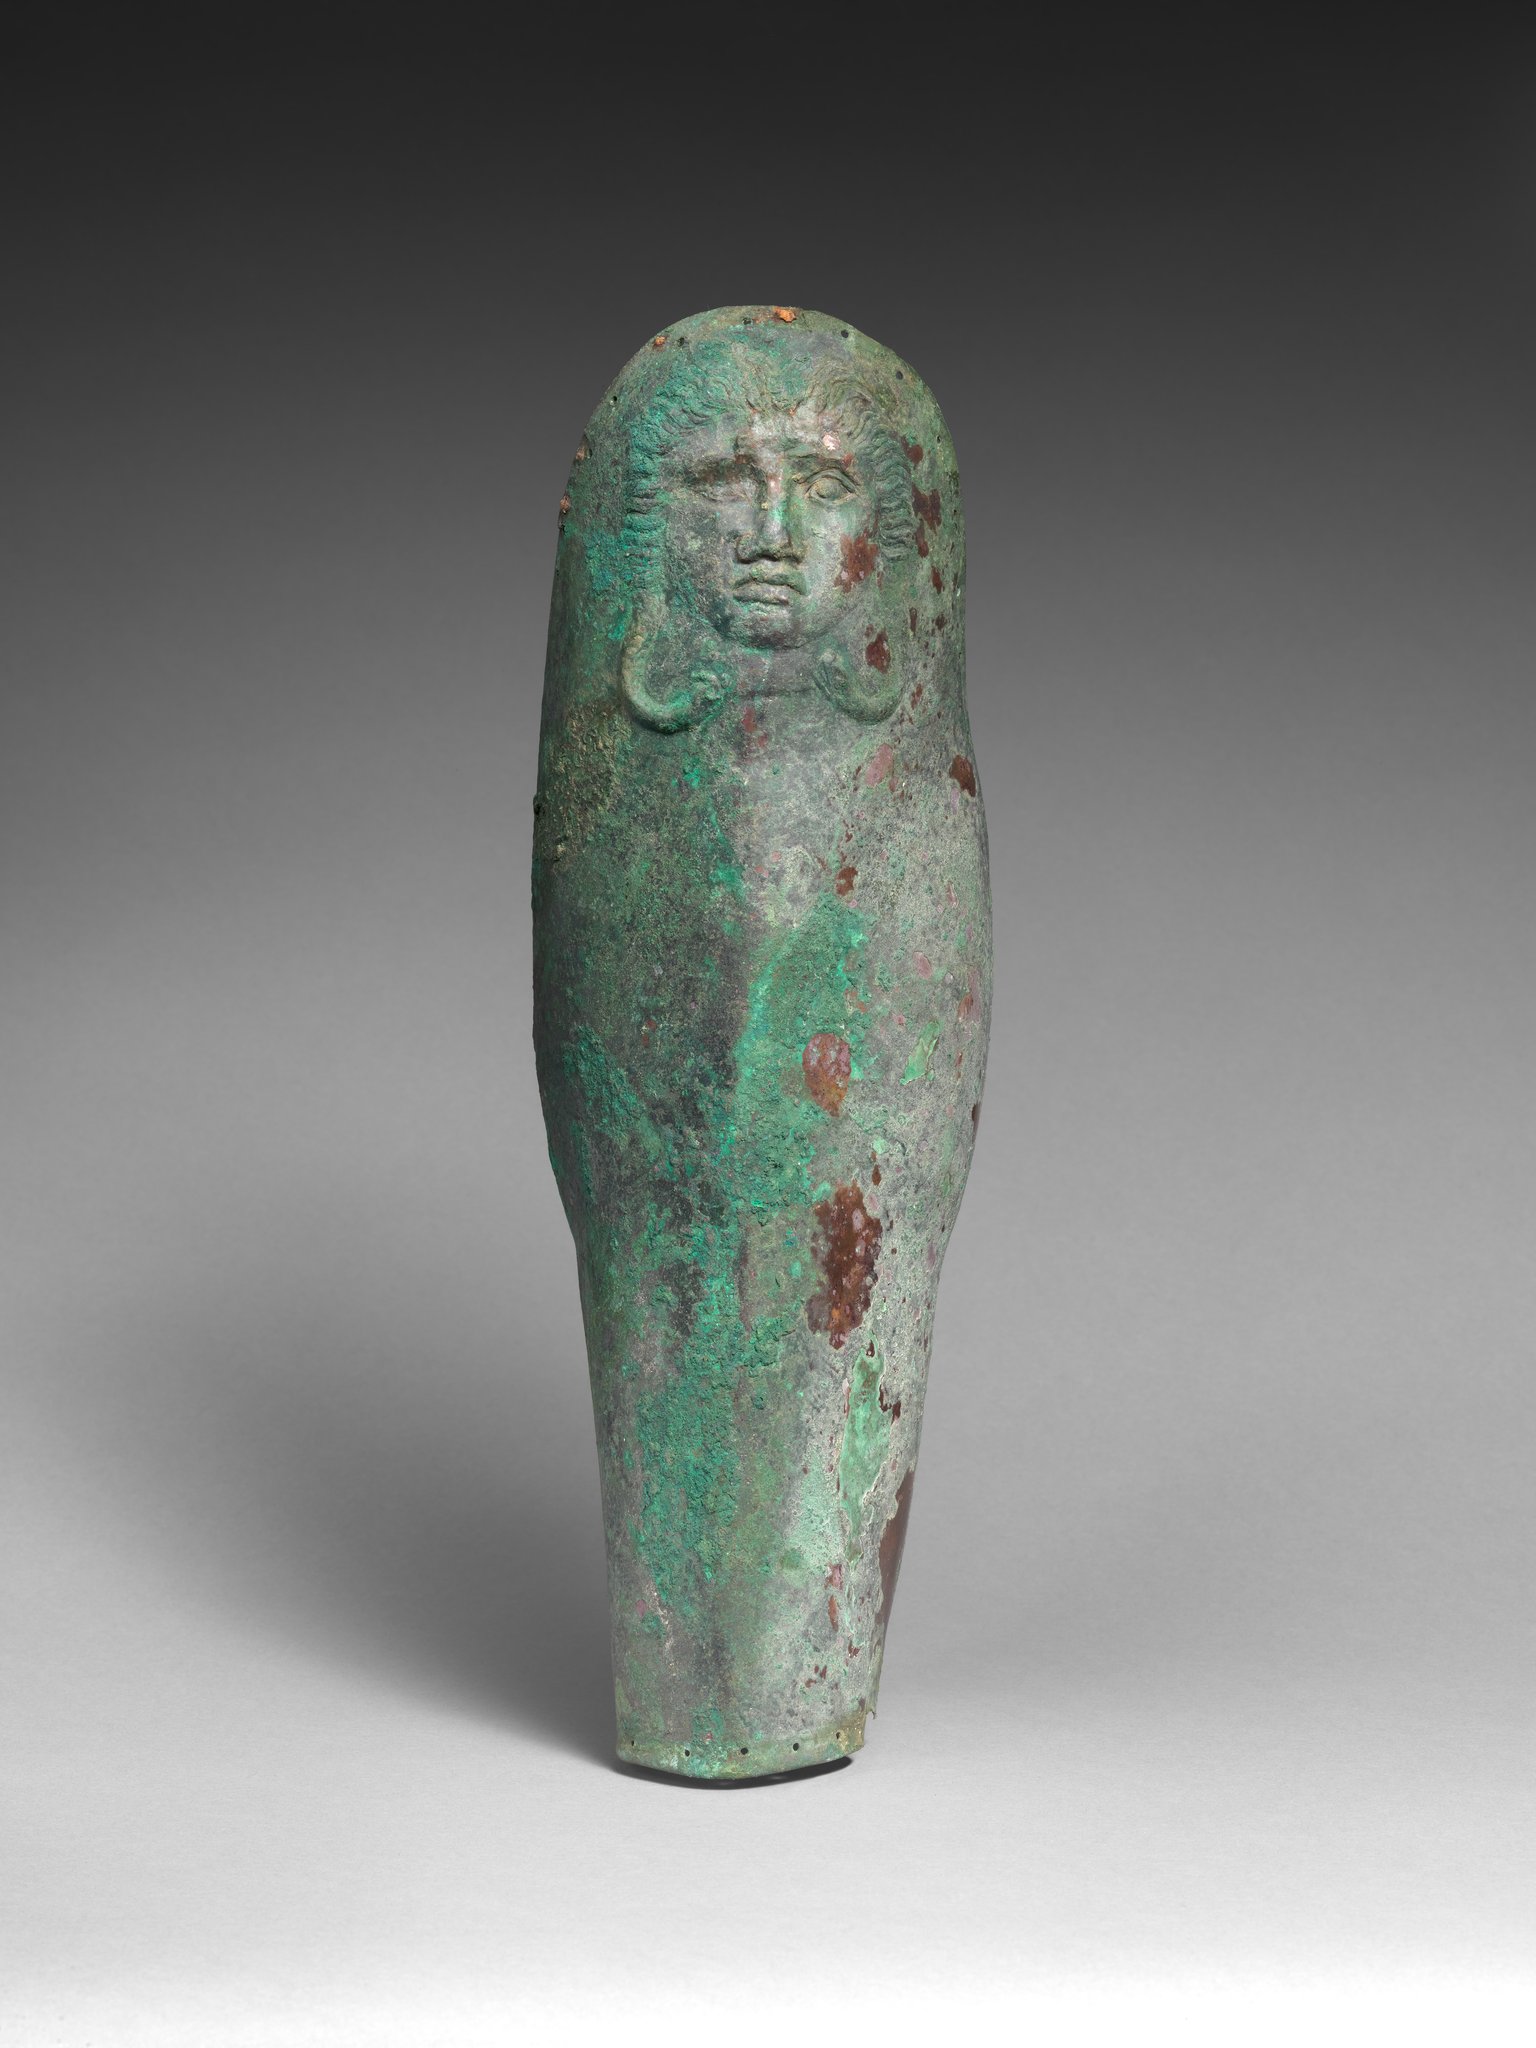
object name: greave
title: Bronze greave (shin guard)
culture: greek or south italian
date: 400-301 BCE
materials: bronze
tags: gorgons